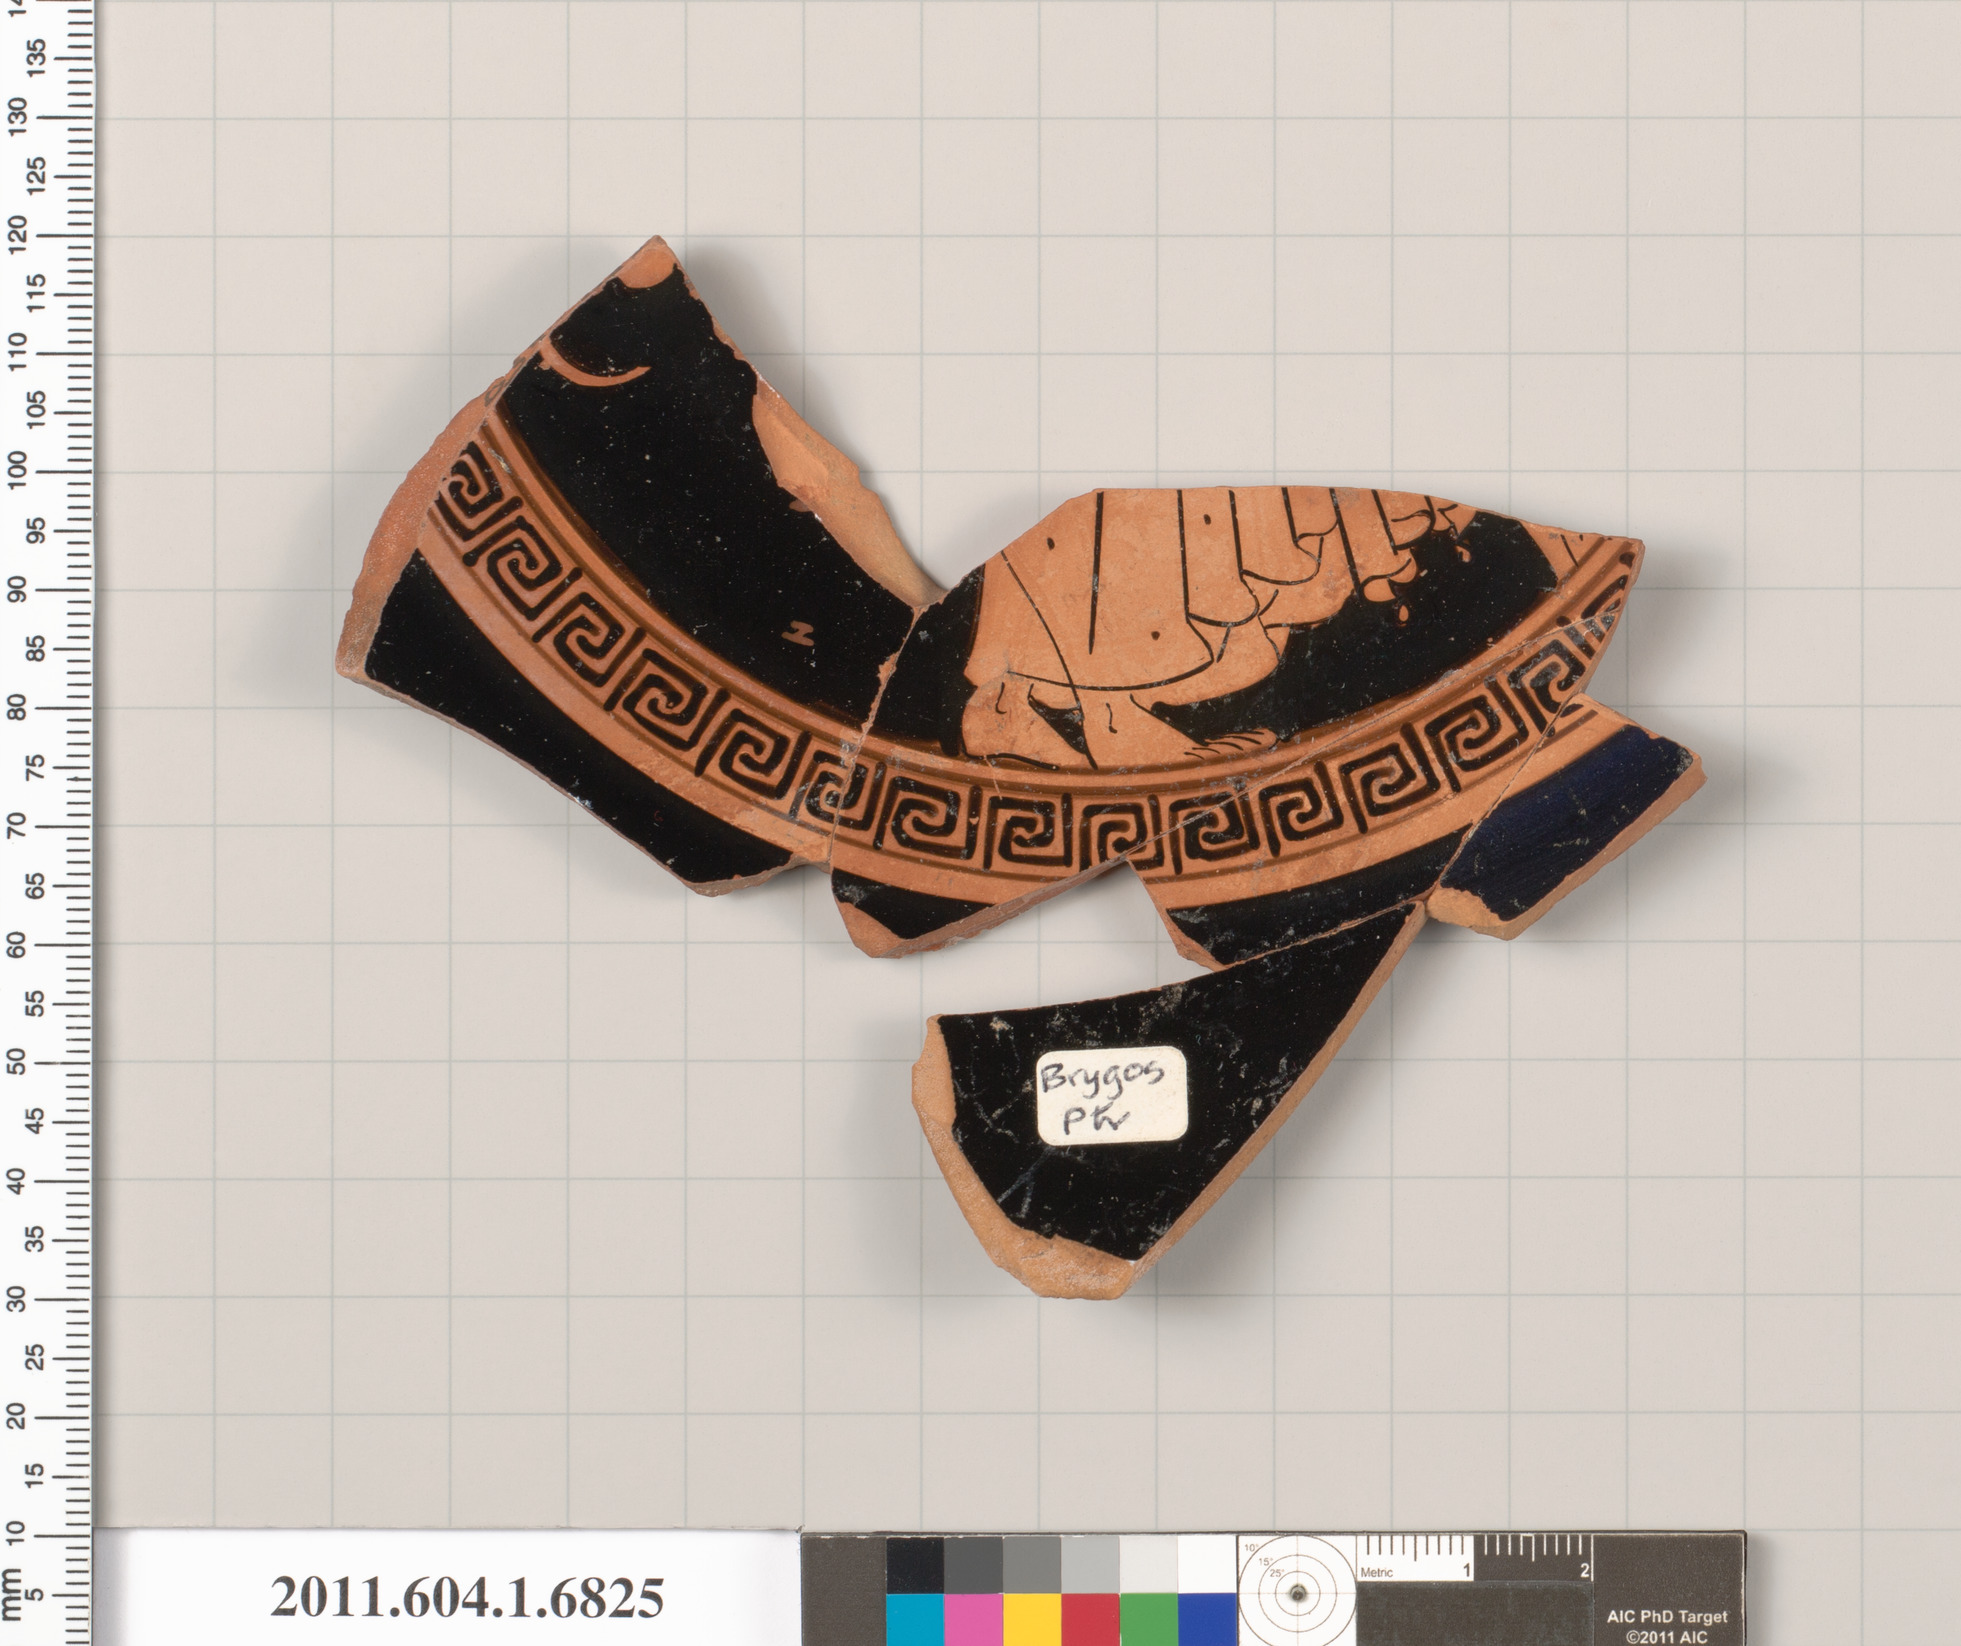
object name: kylix fragment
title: Terracotta fragment of a kylix (drinking cup)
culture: greek, attic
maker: brygos painter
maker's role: artist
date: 490-470 BCE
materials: terracotta